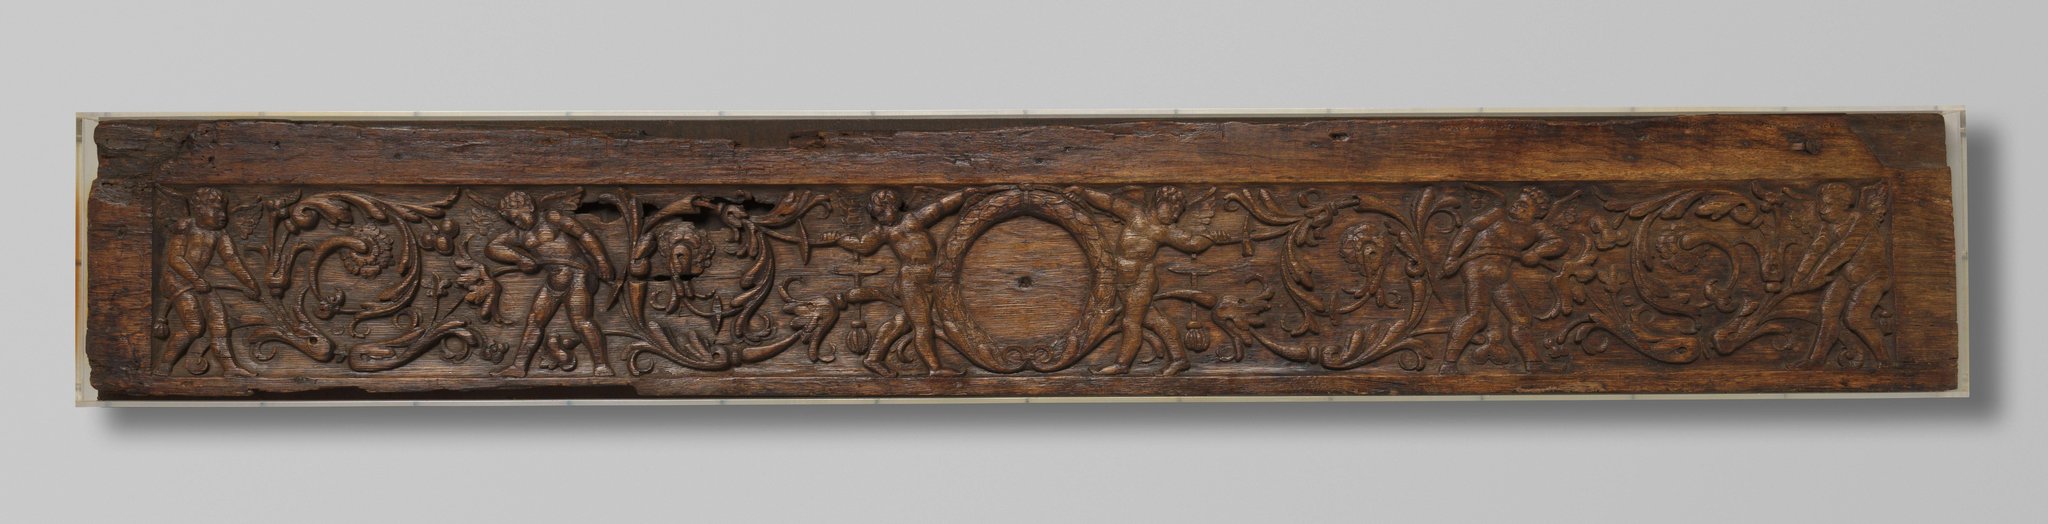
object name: frieze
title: Fries van eikenhout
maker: Anonymous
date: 1550-1599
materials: wood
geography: northern netherlands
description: Fries van eikenhout, op uitgegrond veld symmetrisch versierd met gebeeldhouwde acanthusranken en amoretten, van wie er twee in het midden een lauwerkrans houden. Het fries vertoont brandschade. Het veld binnen de lauwerkrans is thans leeg.